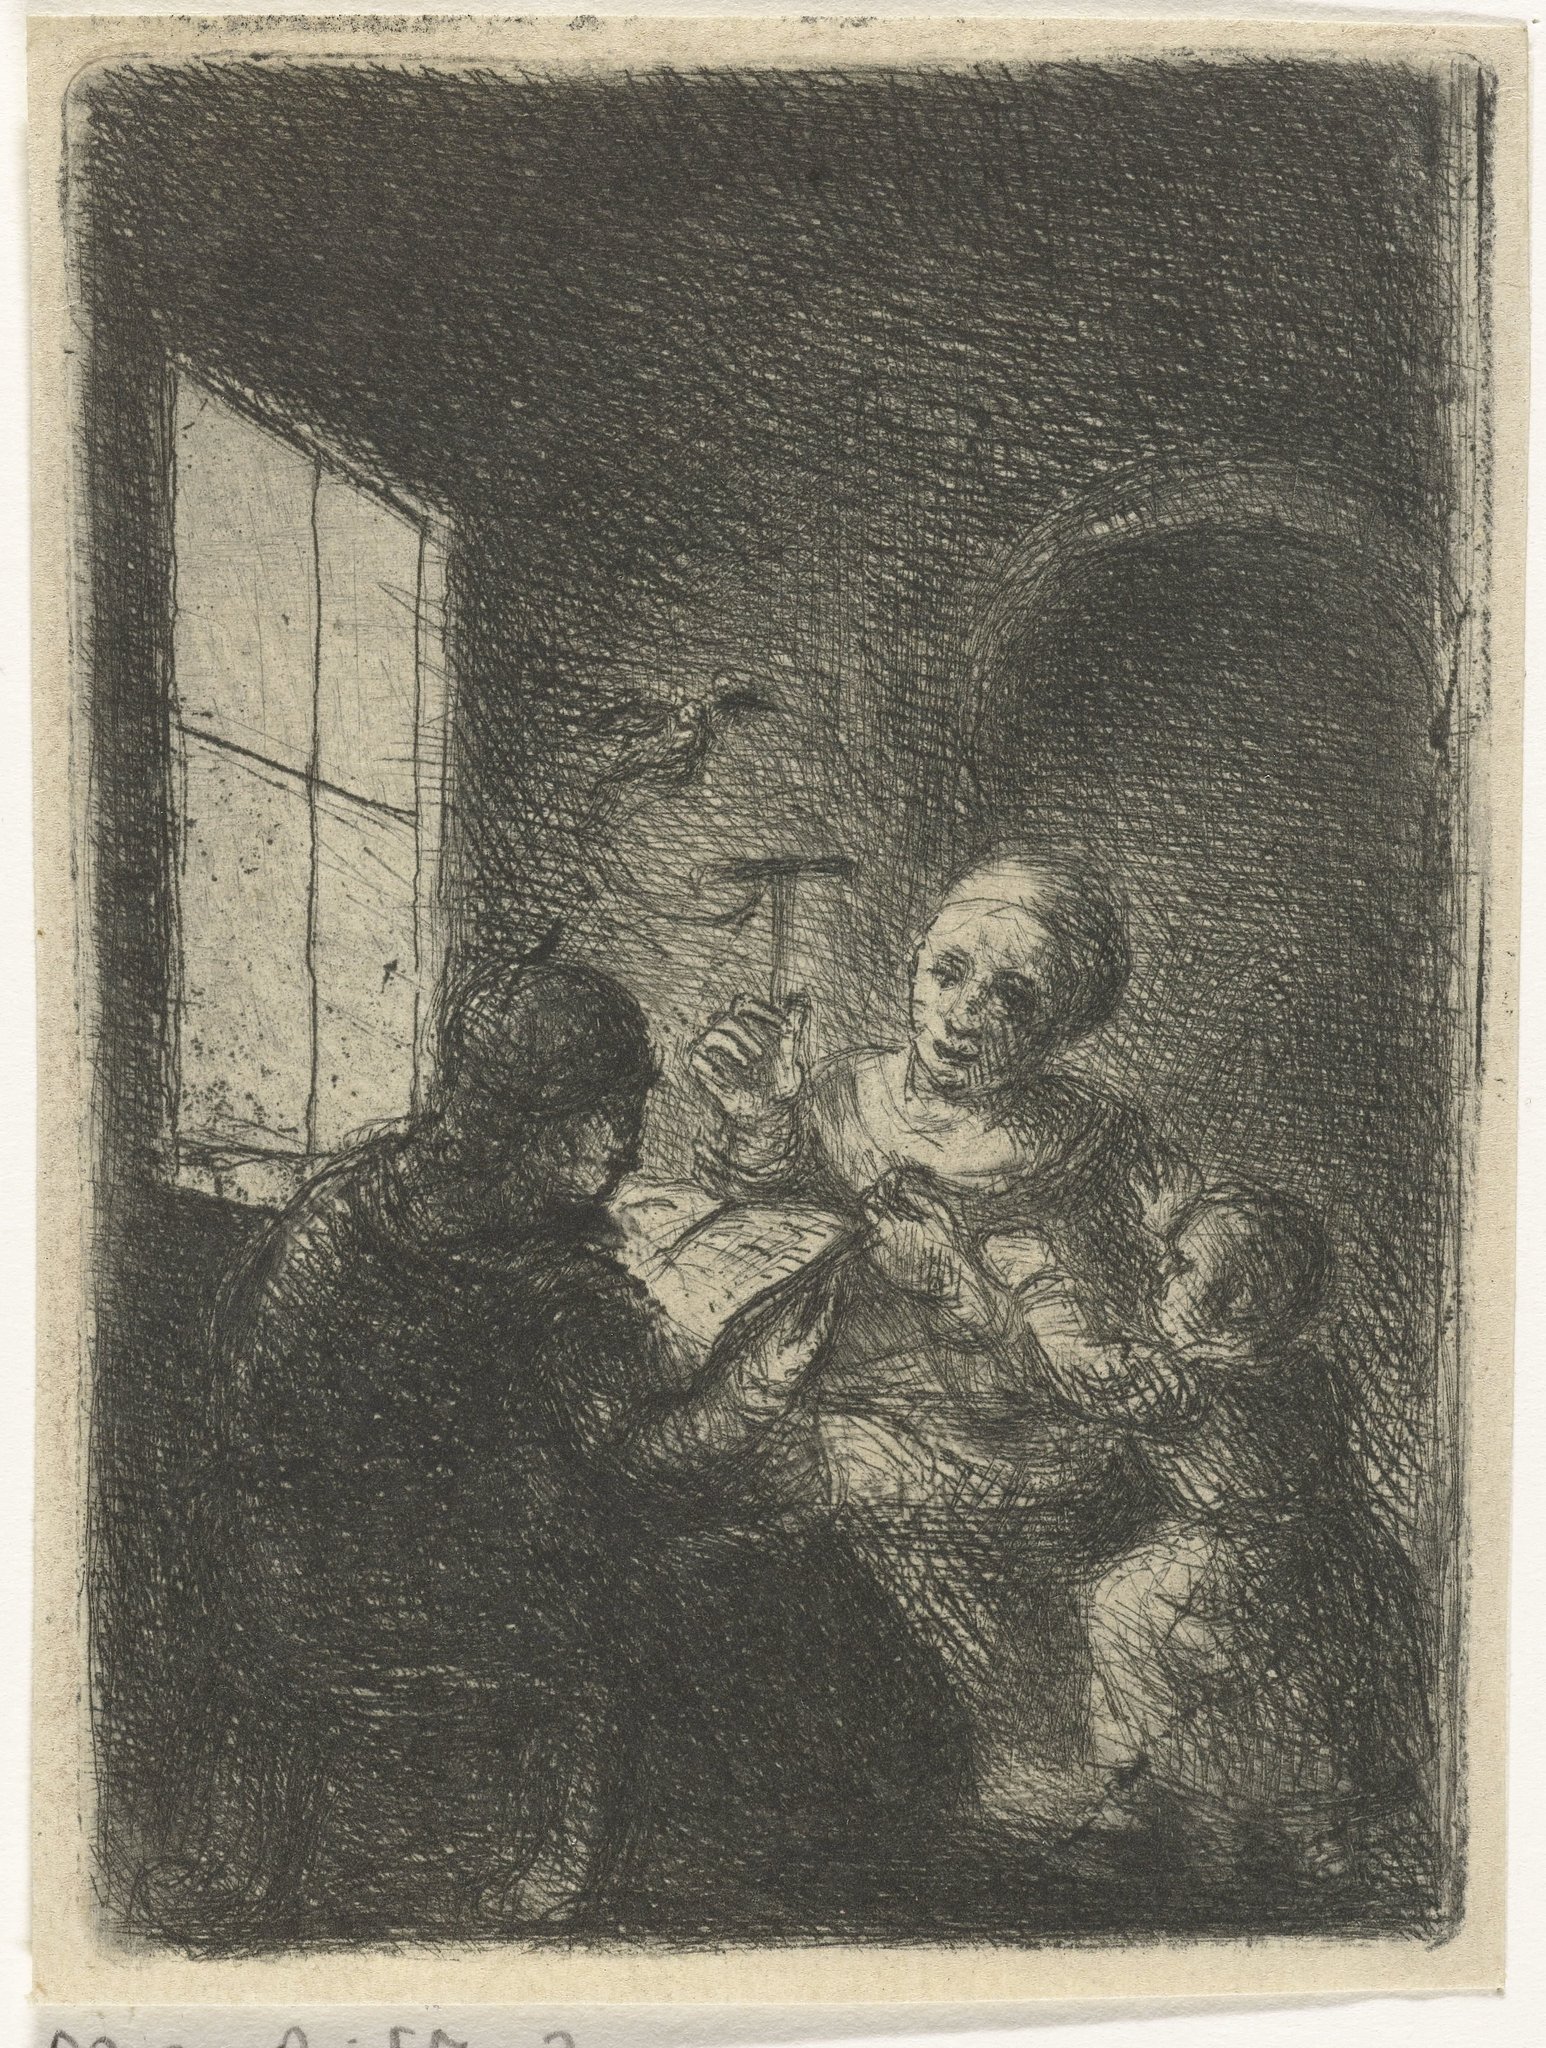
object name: print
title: Interieur met gezin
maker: jan chalon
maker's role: print maker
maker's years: 1738-1795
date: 1748-1795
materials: paper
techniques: drypoint, etching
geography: northern netherlands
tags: family life, living-room, parlour, sitting-room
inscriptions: collector's mark: Lugt 2228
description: Een interieur van een woonkamer. Een gezin bij elkaar. De man leest een boek, terwijl de vrpuw naait en het kind speelt.